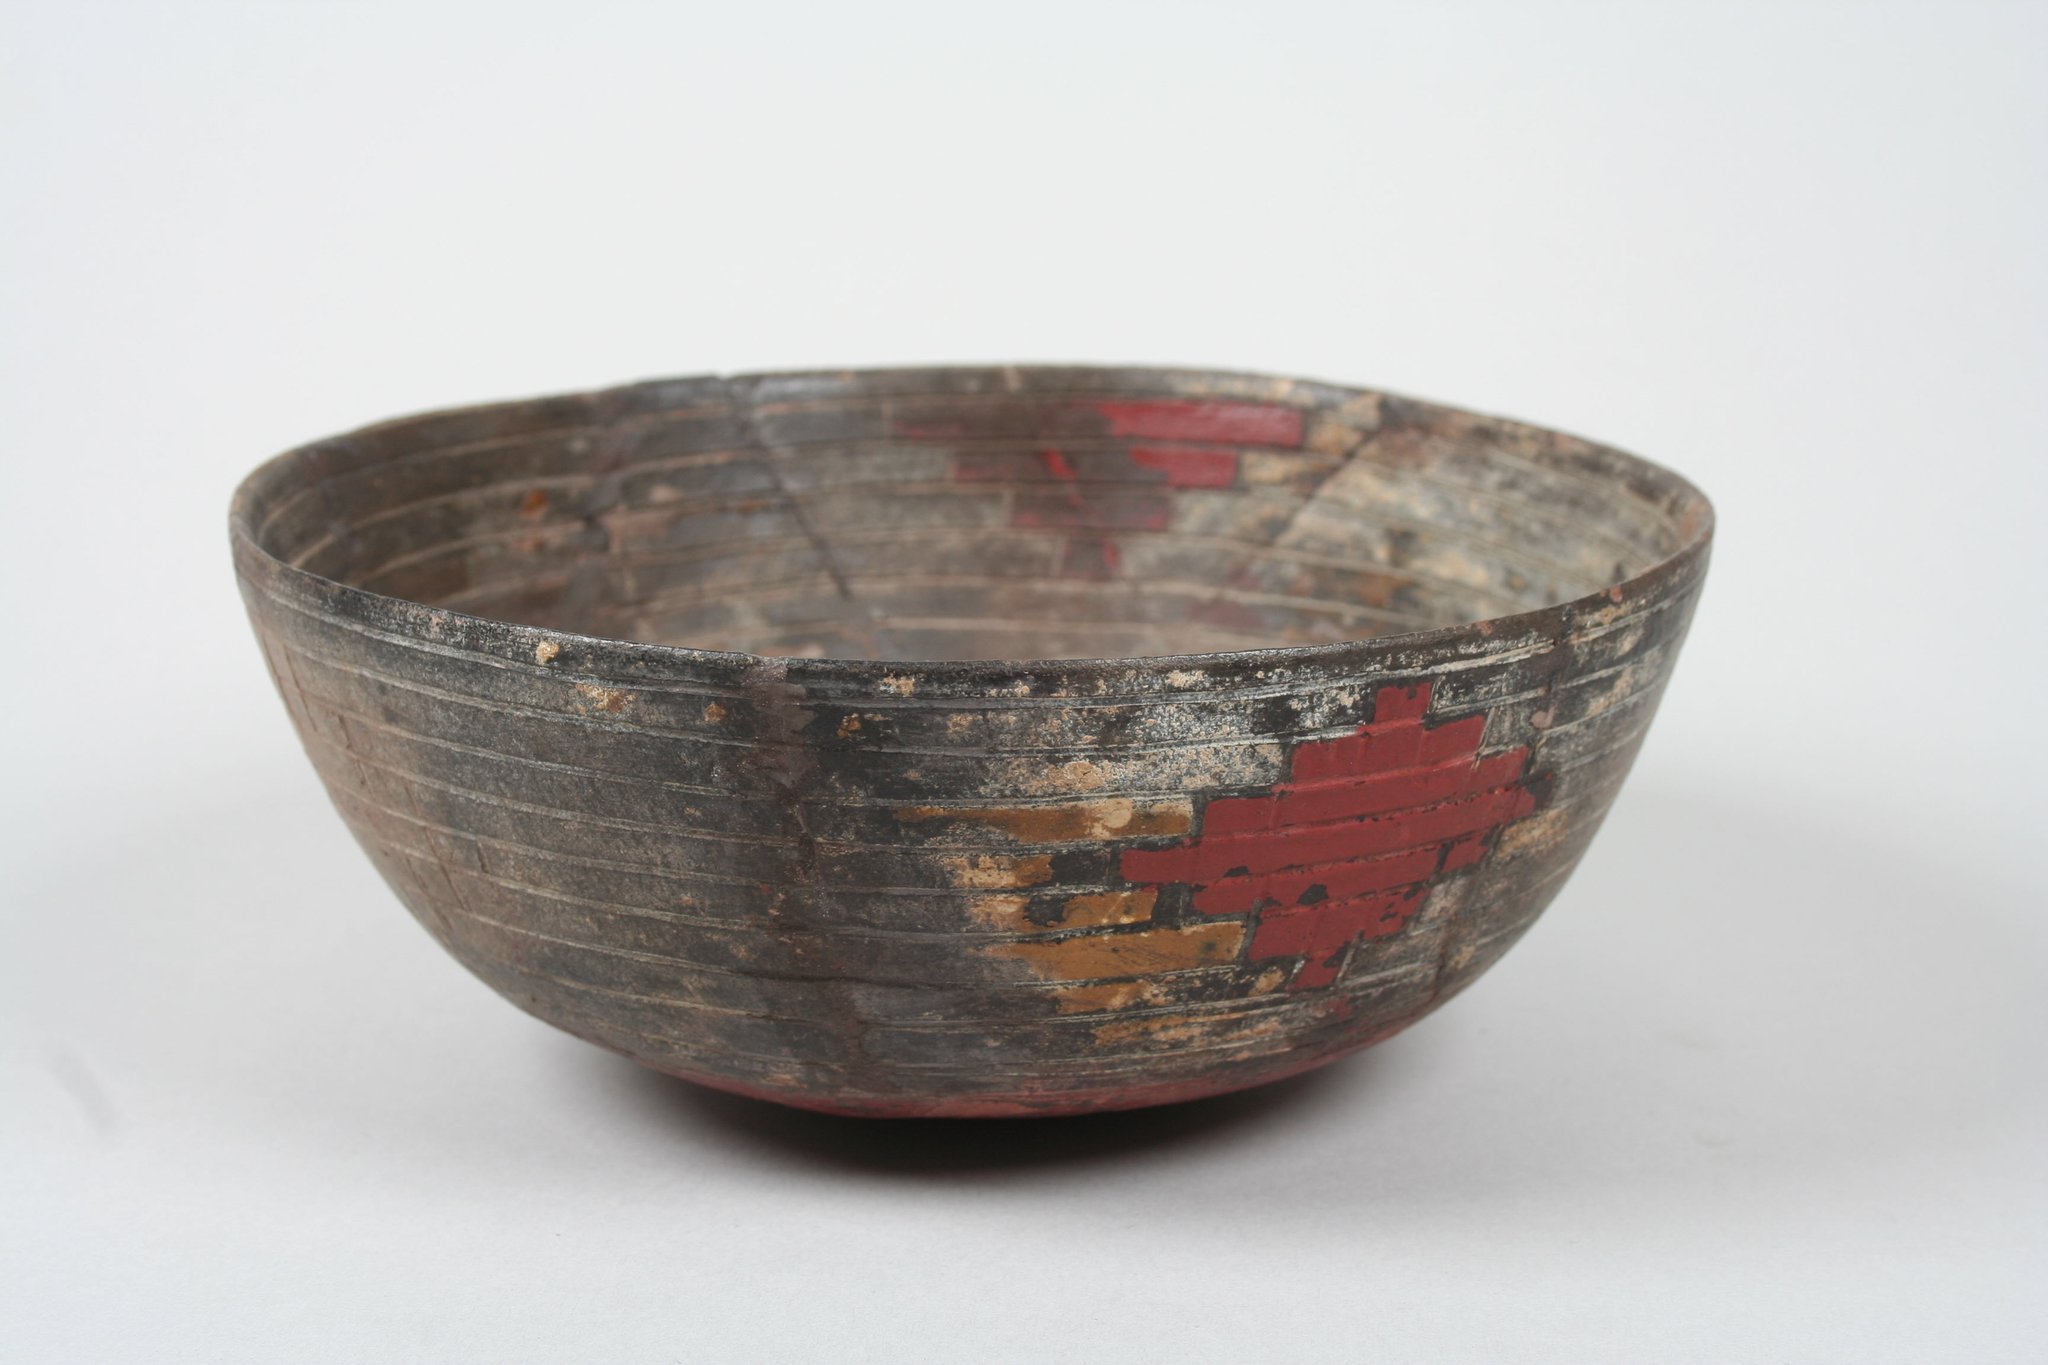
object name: bowl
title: Greyware Bowl with Incised Designs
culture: paracas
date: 300-201 BCE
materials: ceramic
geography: peru